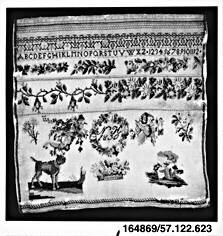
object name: sampler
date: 1830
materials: canvas, silk, wool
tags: dogs,flowers